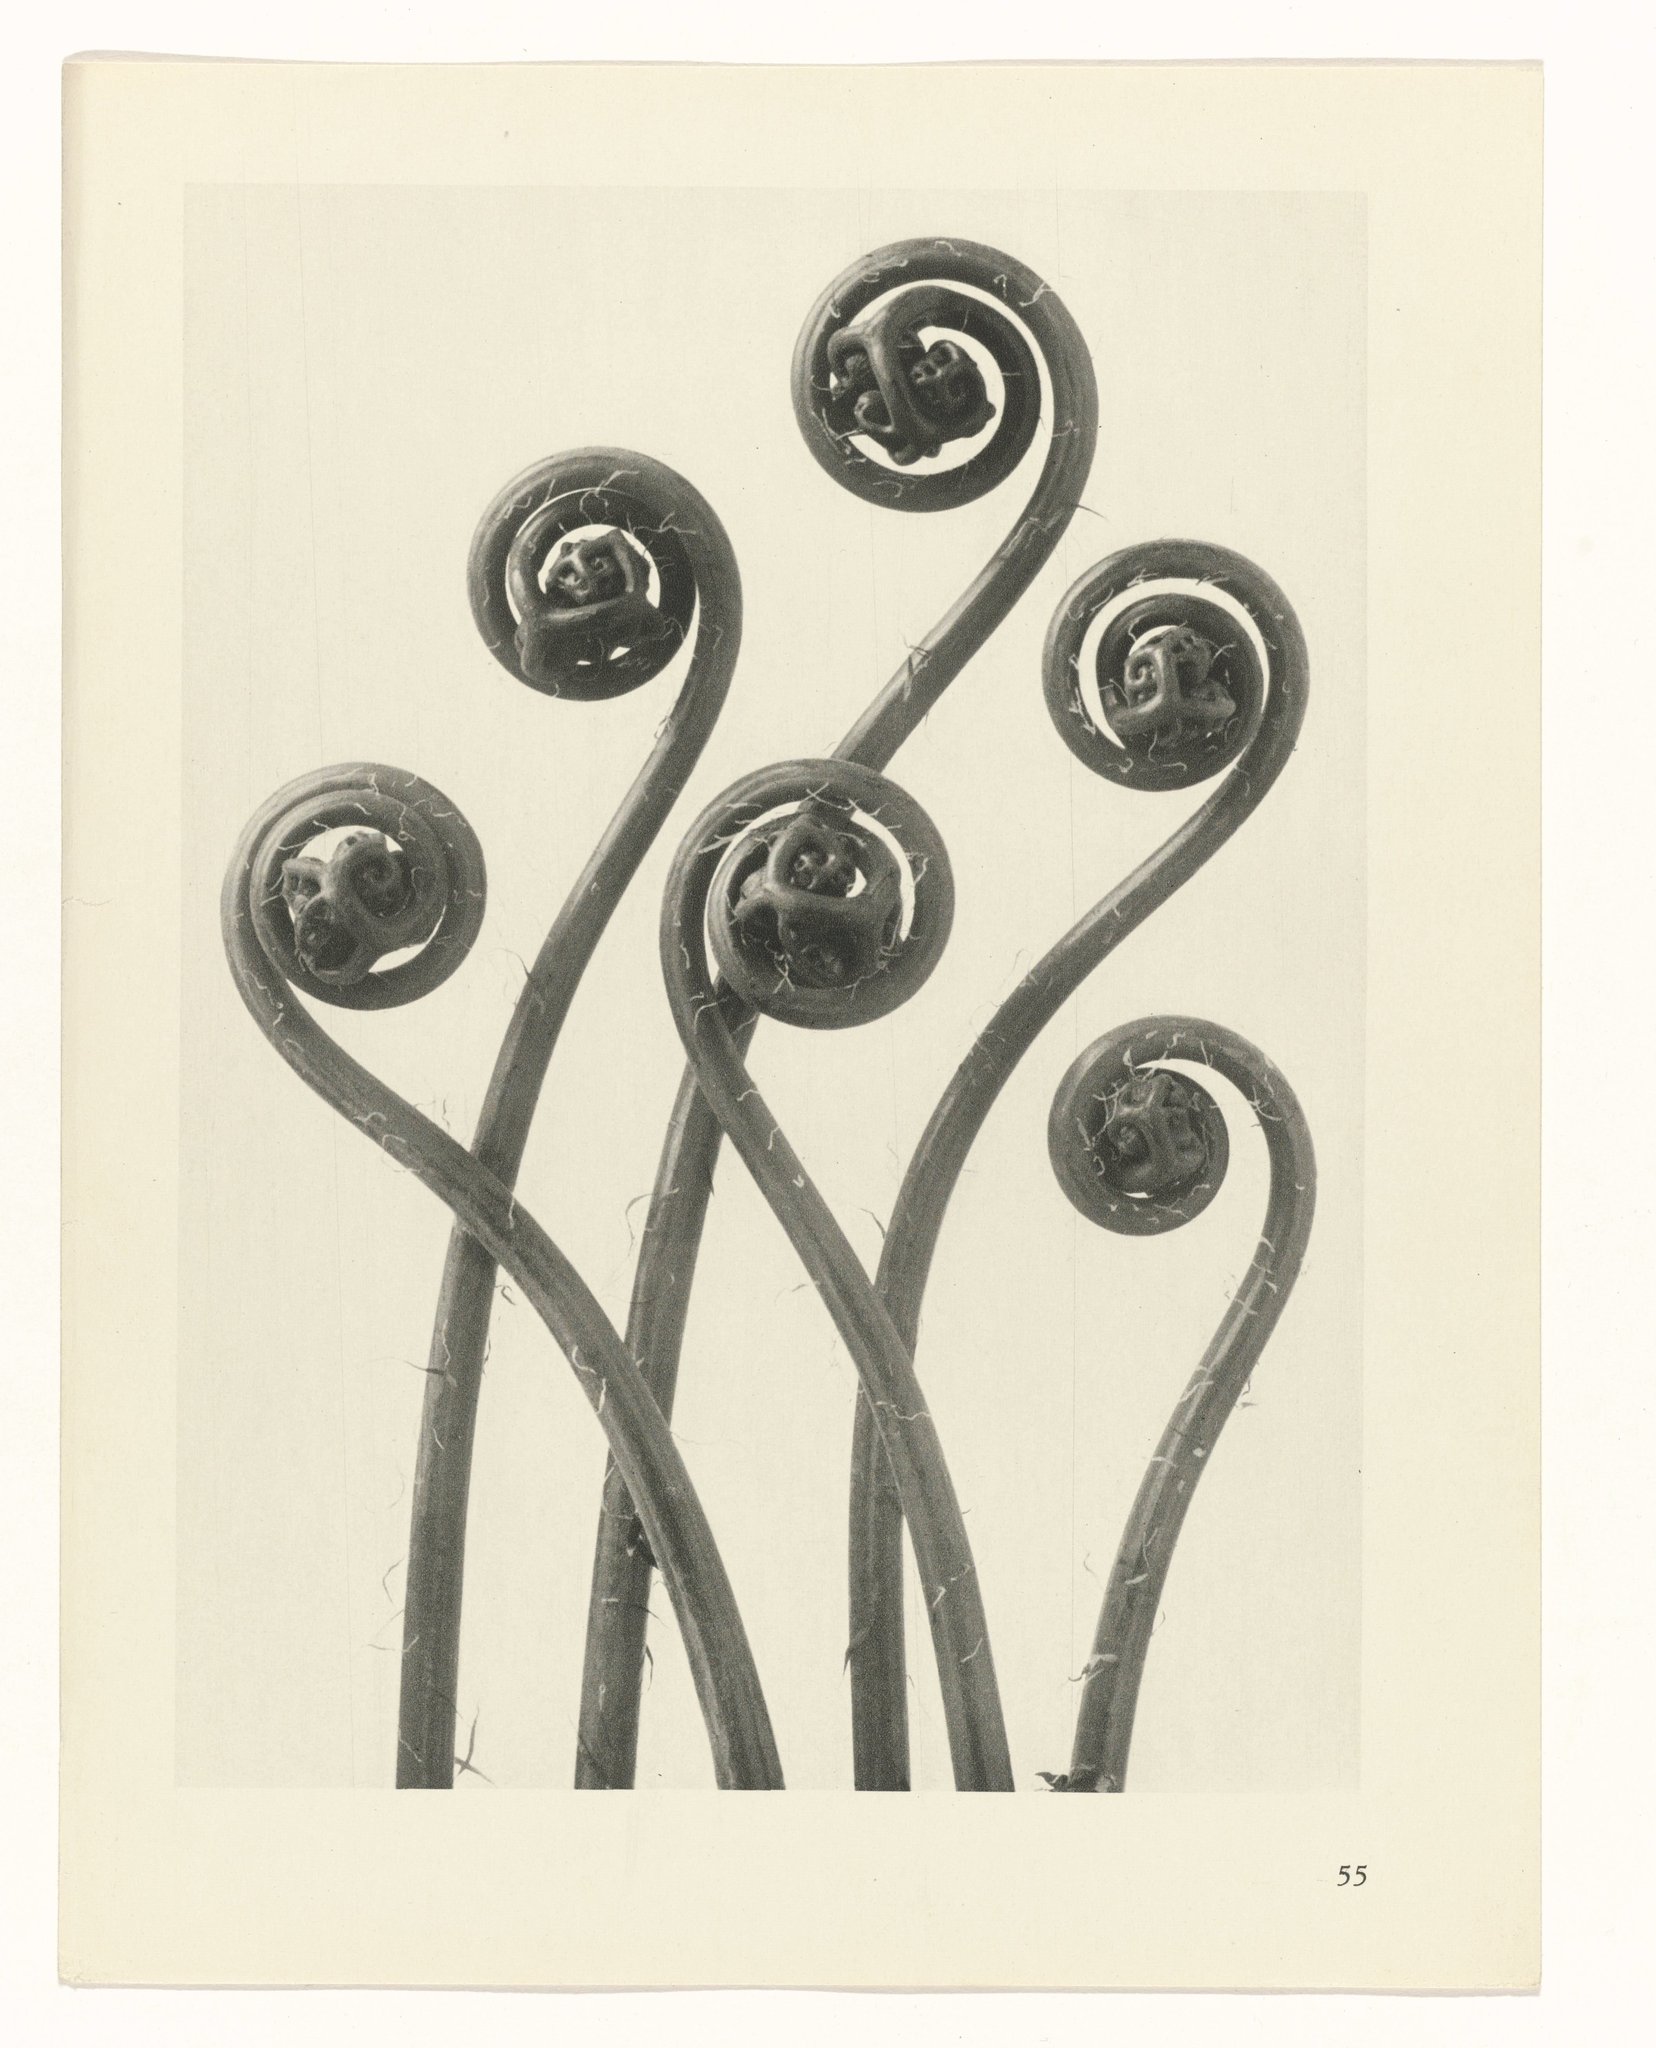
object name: photograph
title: Urformen der Kunst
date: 1928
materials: ink, paper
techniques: rotogravure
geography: berlin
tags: plants (in general)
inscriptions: number: ‘55’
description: facher Vergrößerung. Afkomstig uit losbladige uitgave.